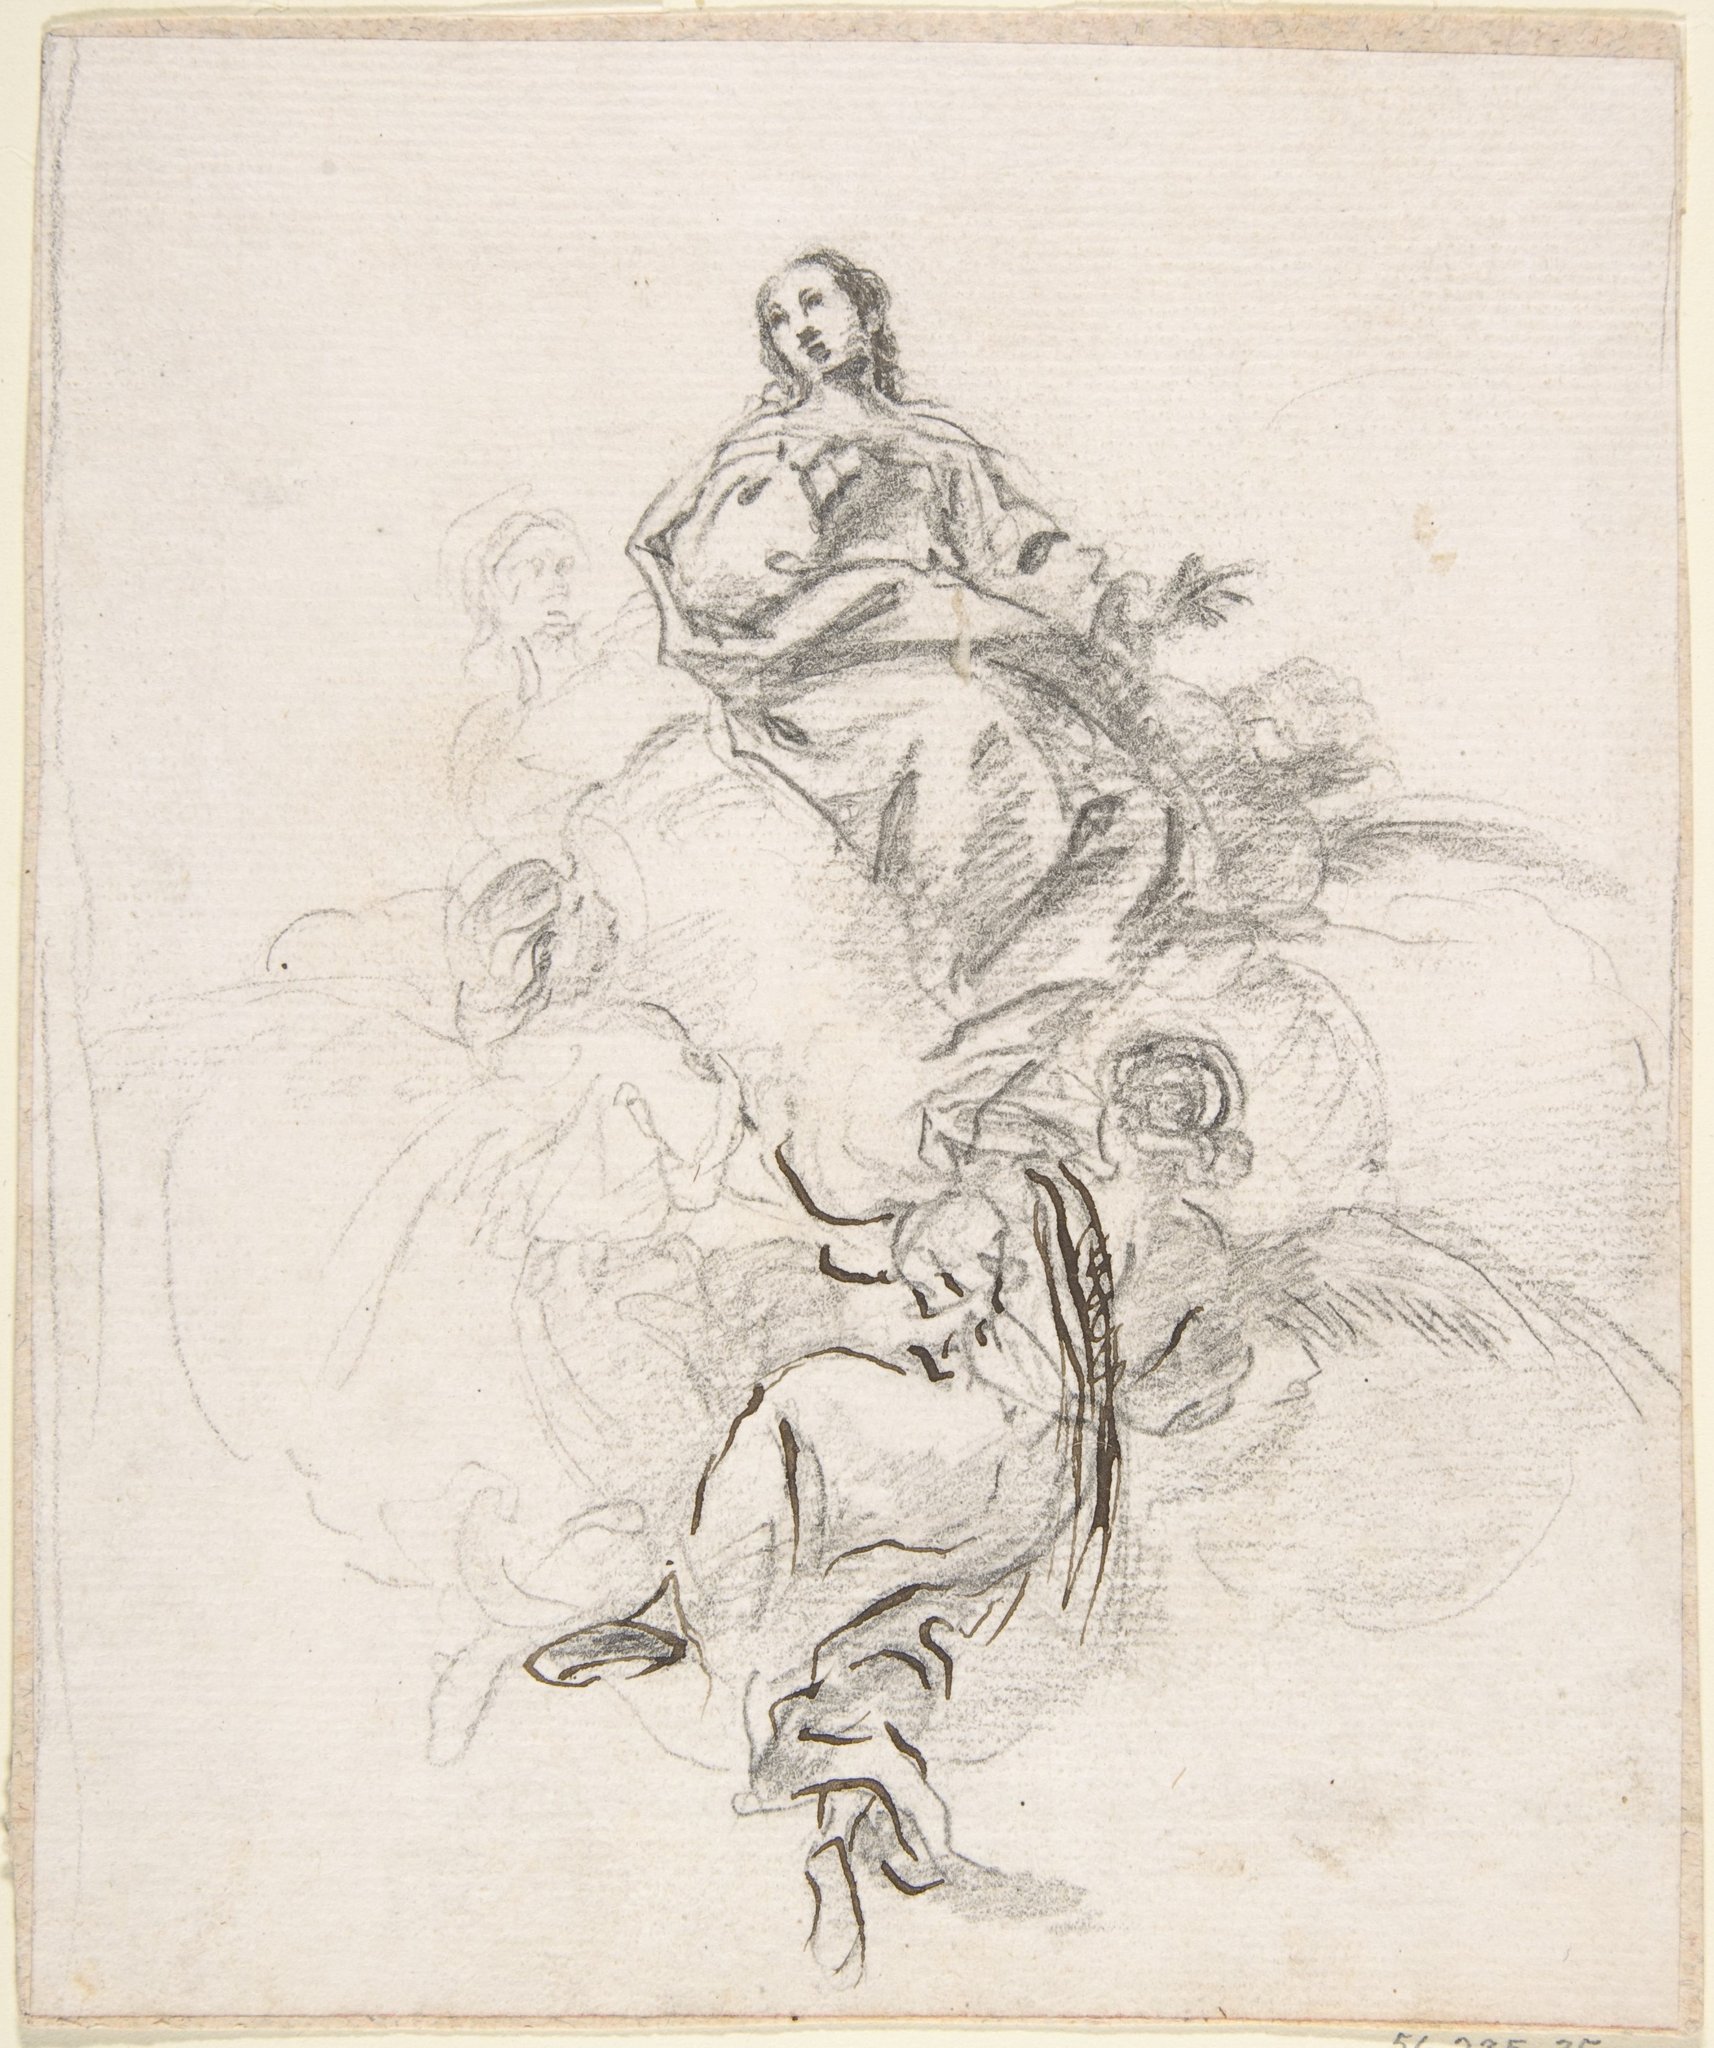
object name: drawing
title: Virgin of the Immaculate Conception Seated on Clouds, Supported by Four Angels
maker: pedro duque cornejo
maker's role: artist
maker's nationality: spanish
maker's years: 1677-1757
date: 1700-1750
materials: chalk, ink, paper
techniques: pen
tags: clouds,angels,virgin mary